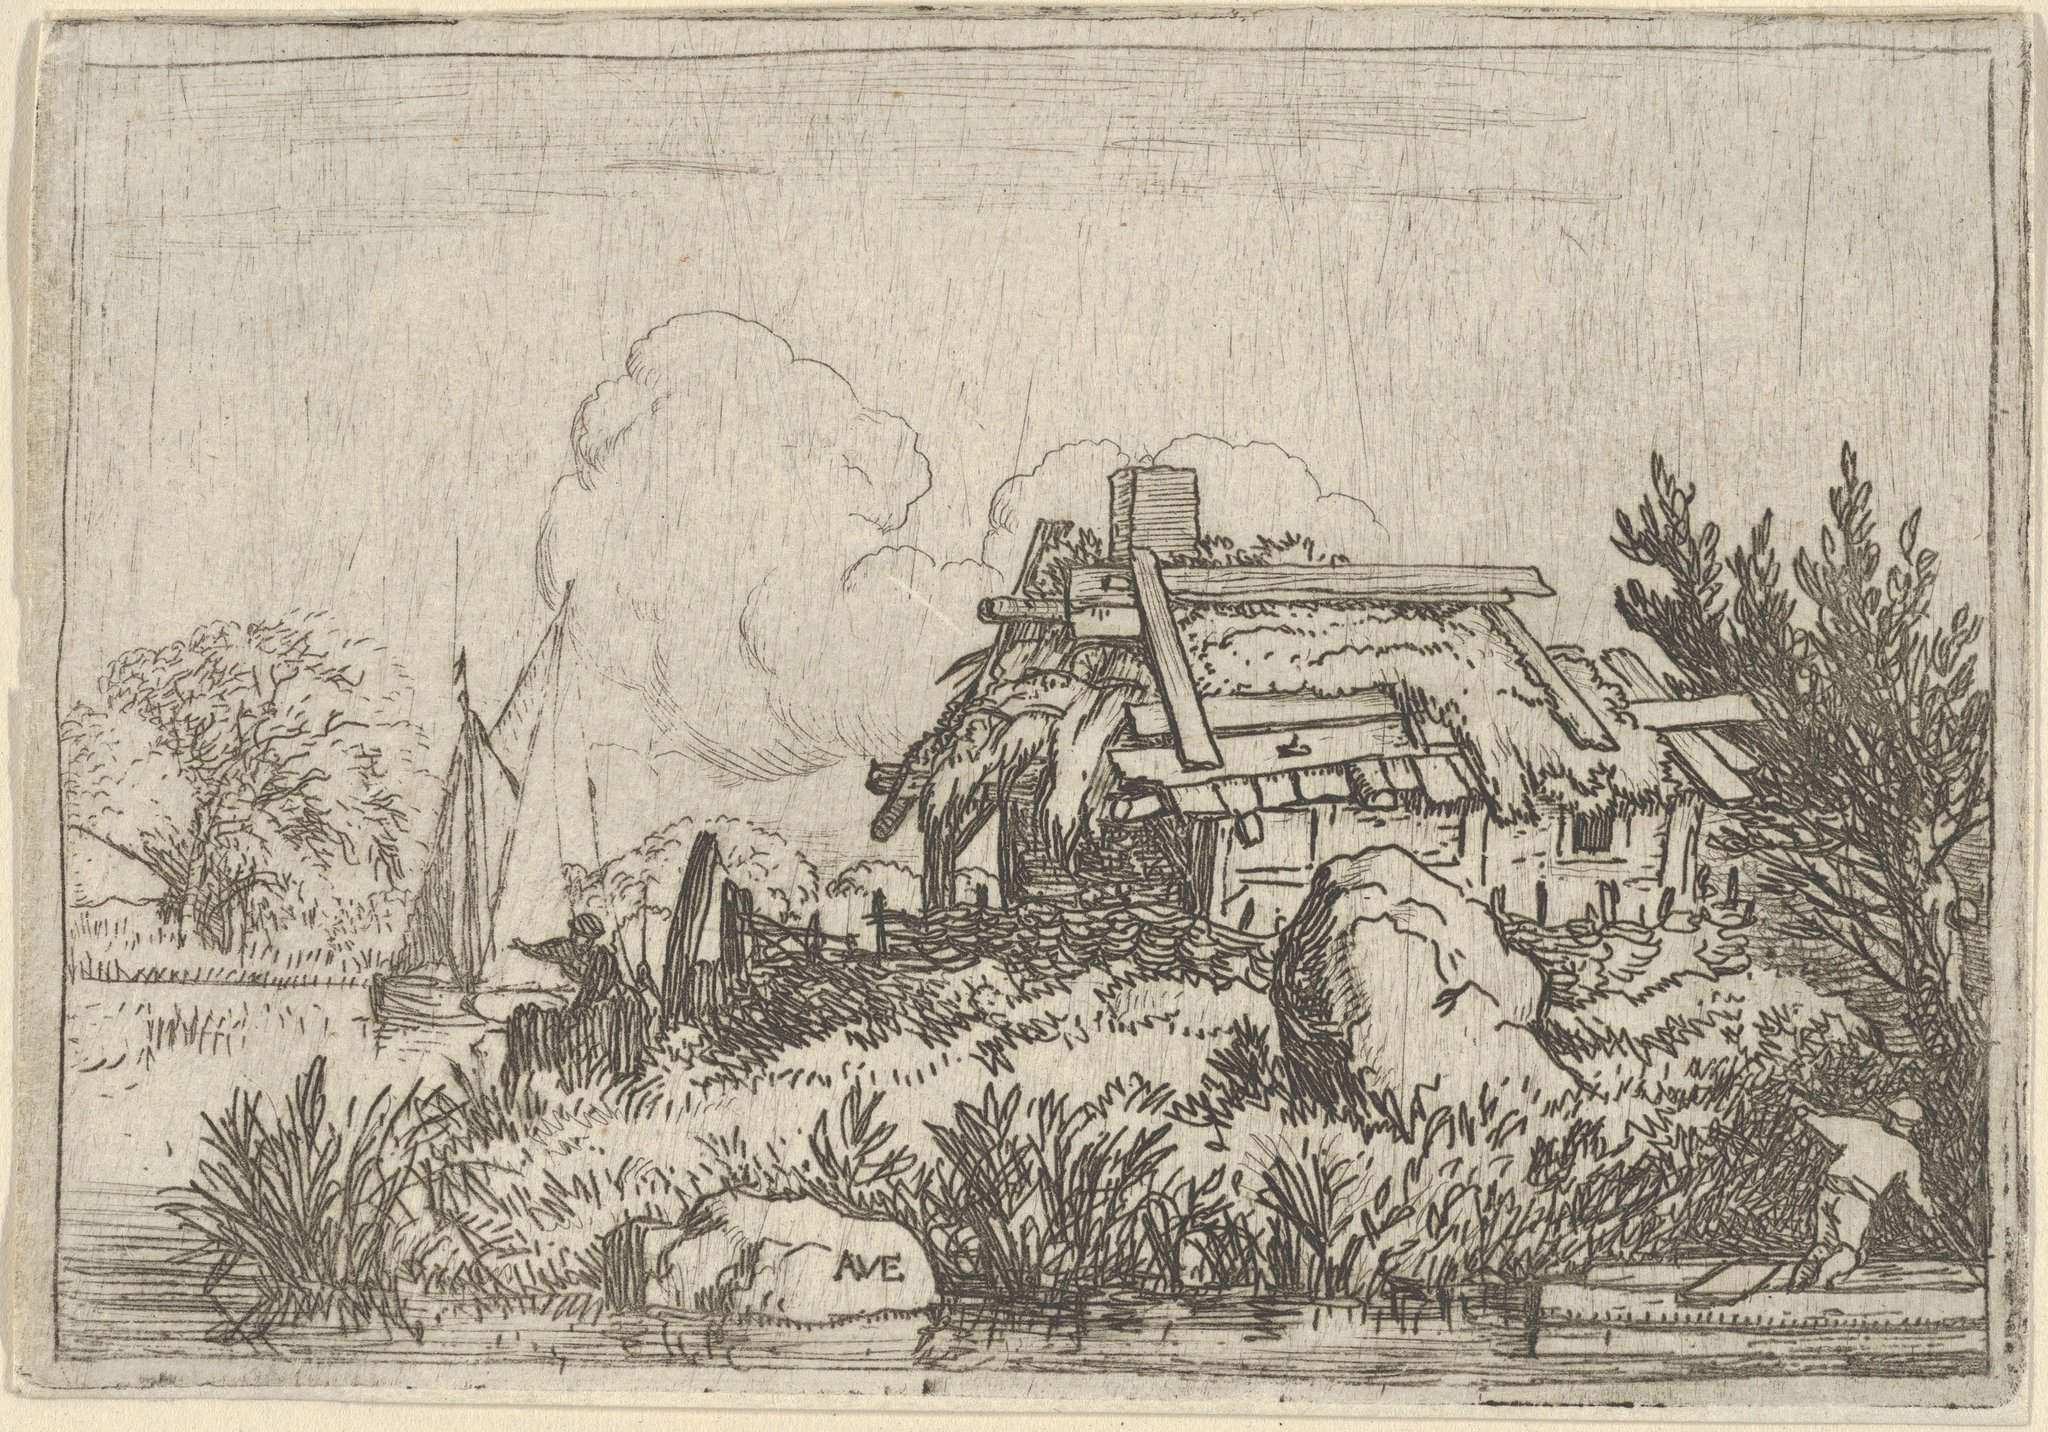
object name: print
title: The Ruined Cottage, Surrounded by Water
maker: allart van everdingen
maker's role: artist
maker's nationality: dutch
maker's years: 1621-1675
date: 1621-1675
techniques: engraving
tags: houses,ruins